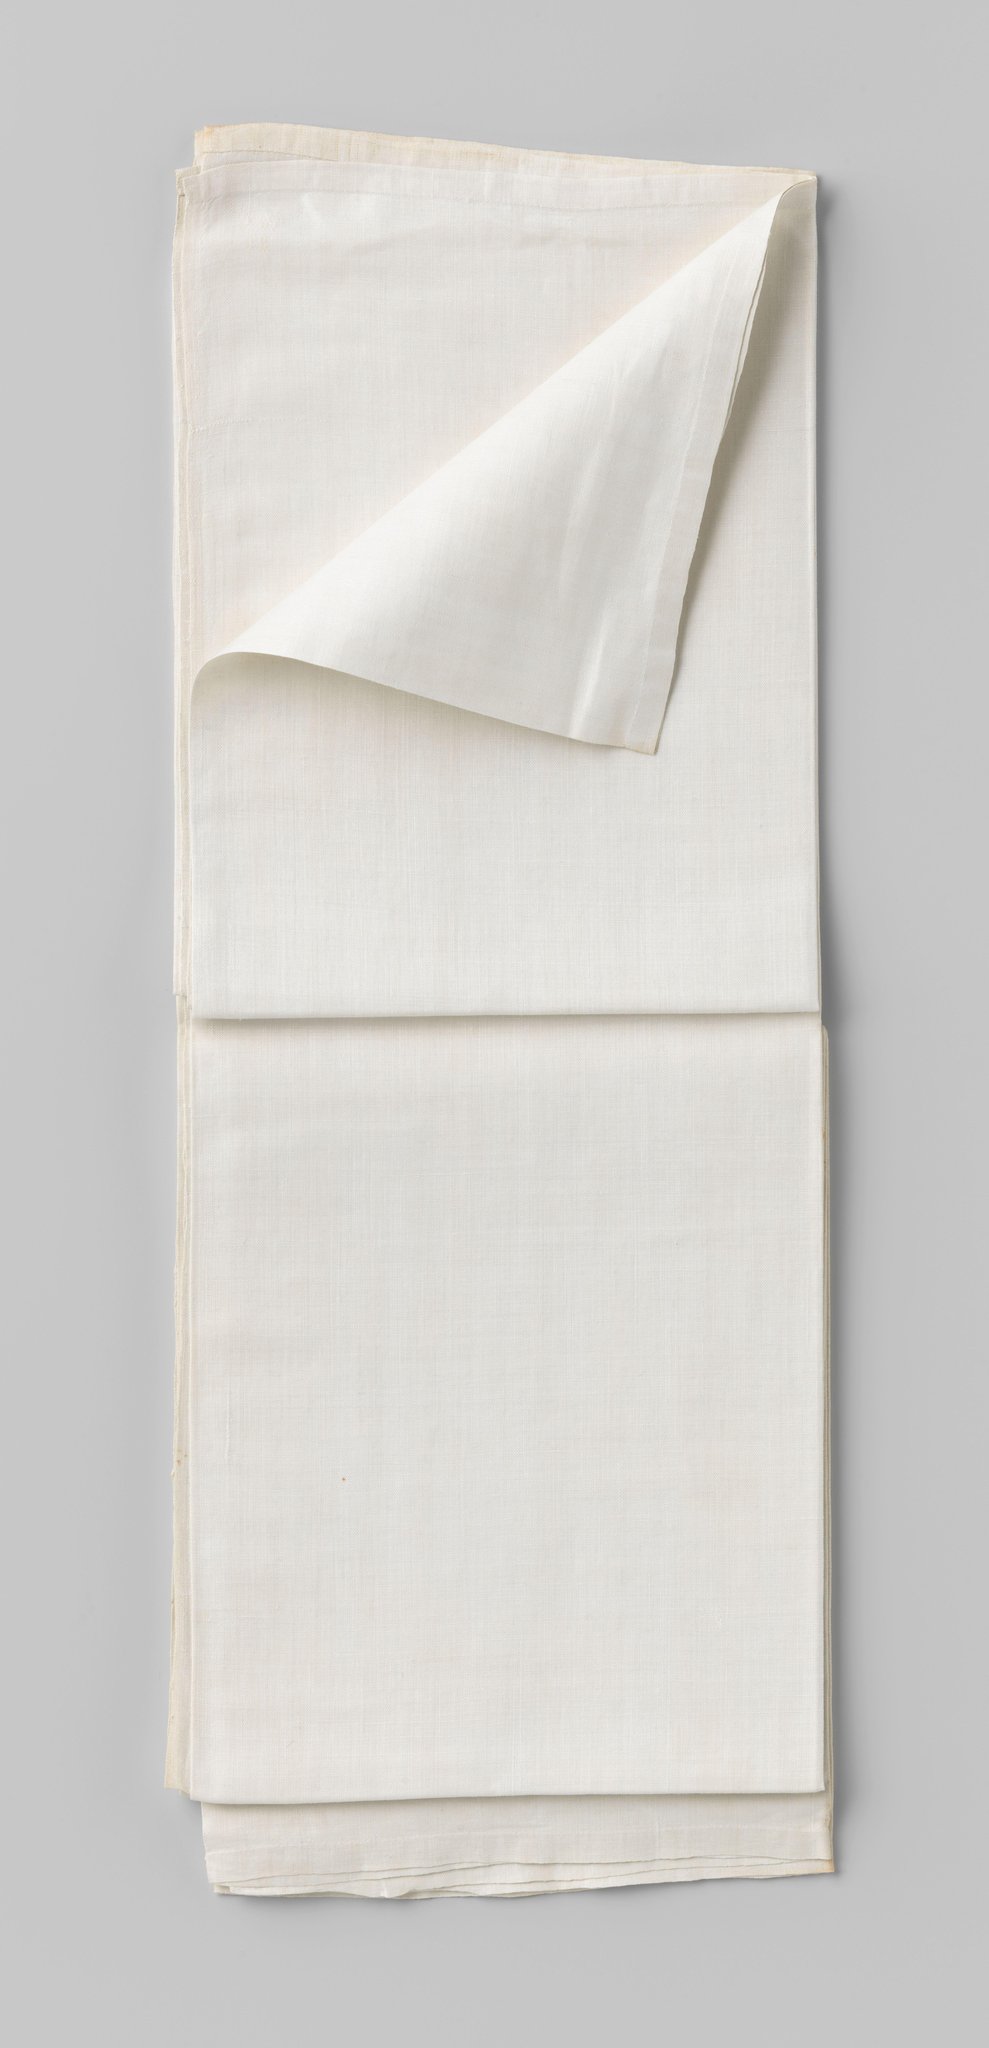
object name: kinderlaken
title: Kinderlaken. Merk: HW 18.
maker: Anonymous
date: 1852-1860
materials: linen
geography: northern netherlands